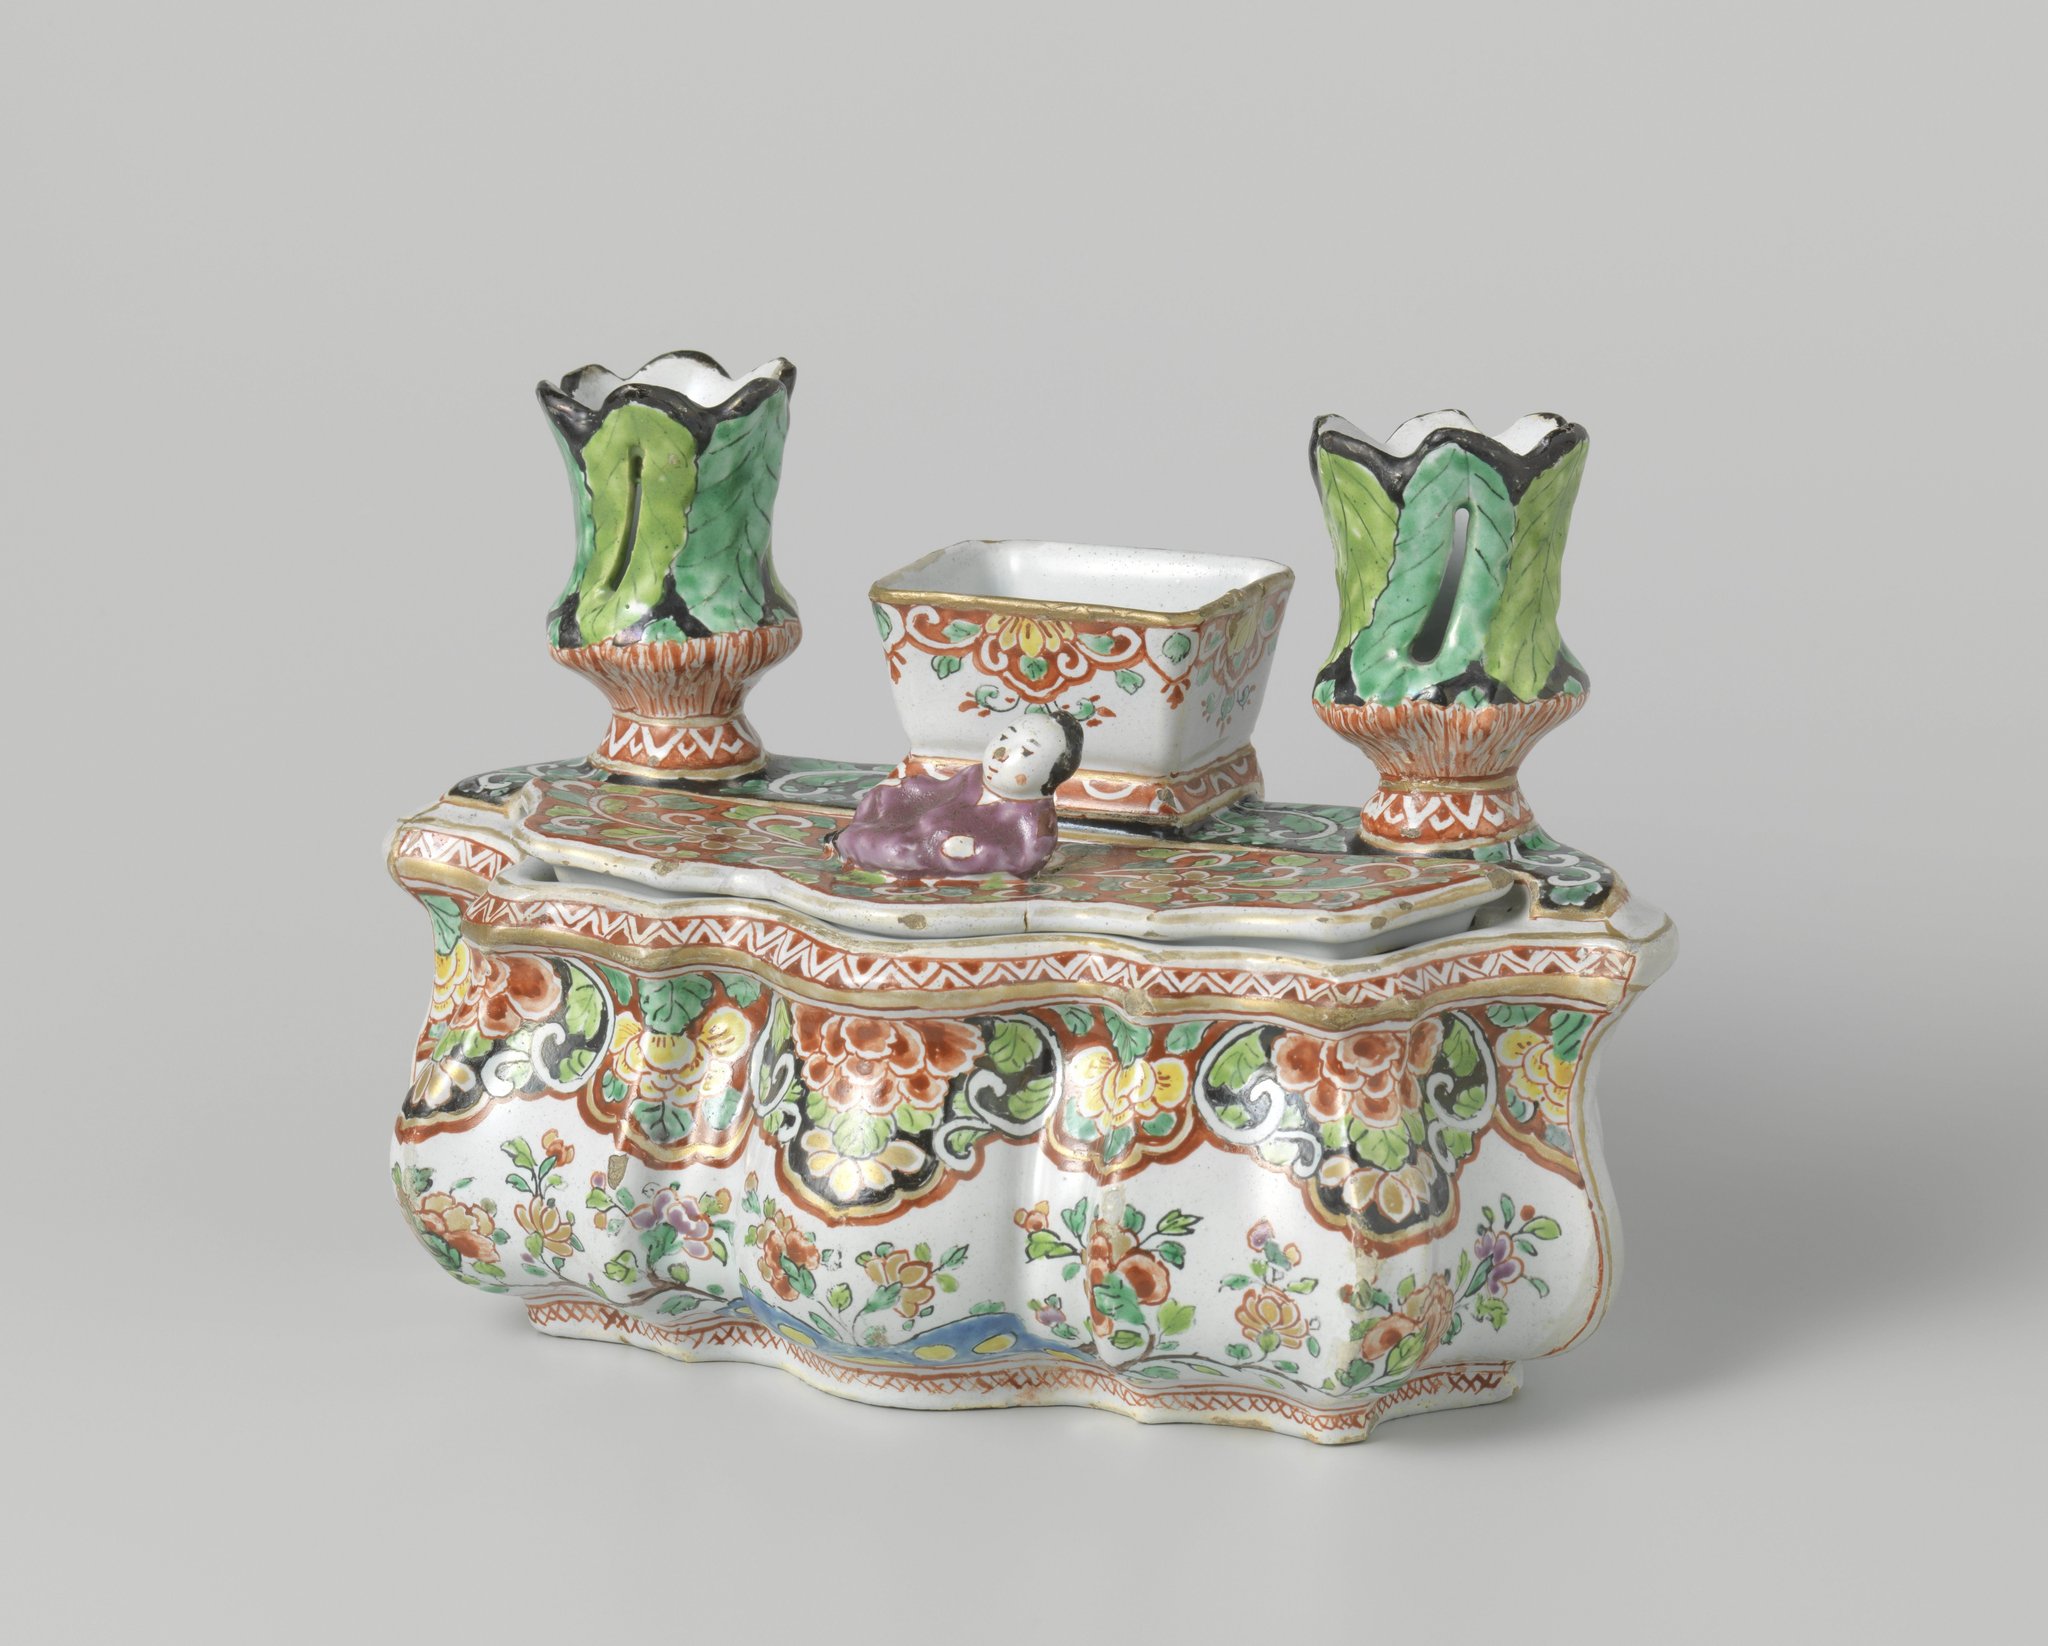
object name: inkstand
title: Inktstel van veelkleurig beschilderde faïence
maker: Anonymous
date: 1750-1775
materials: faience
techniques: kiln, painted, polychromy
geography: delft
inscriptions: collector's mark: ‘collection J.F. Loudon’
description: Inkstand. Faience. Delft, c. 1750 - 1775. Given by the heirs of John F. Loudon, 1916.